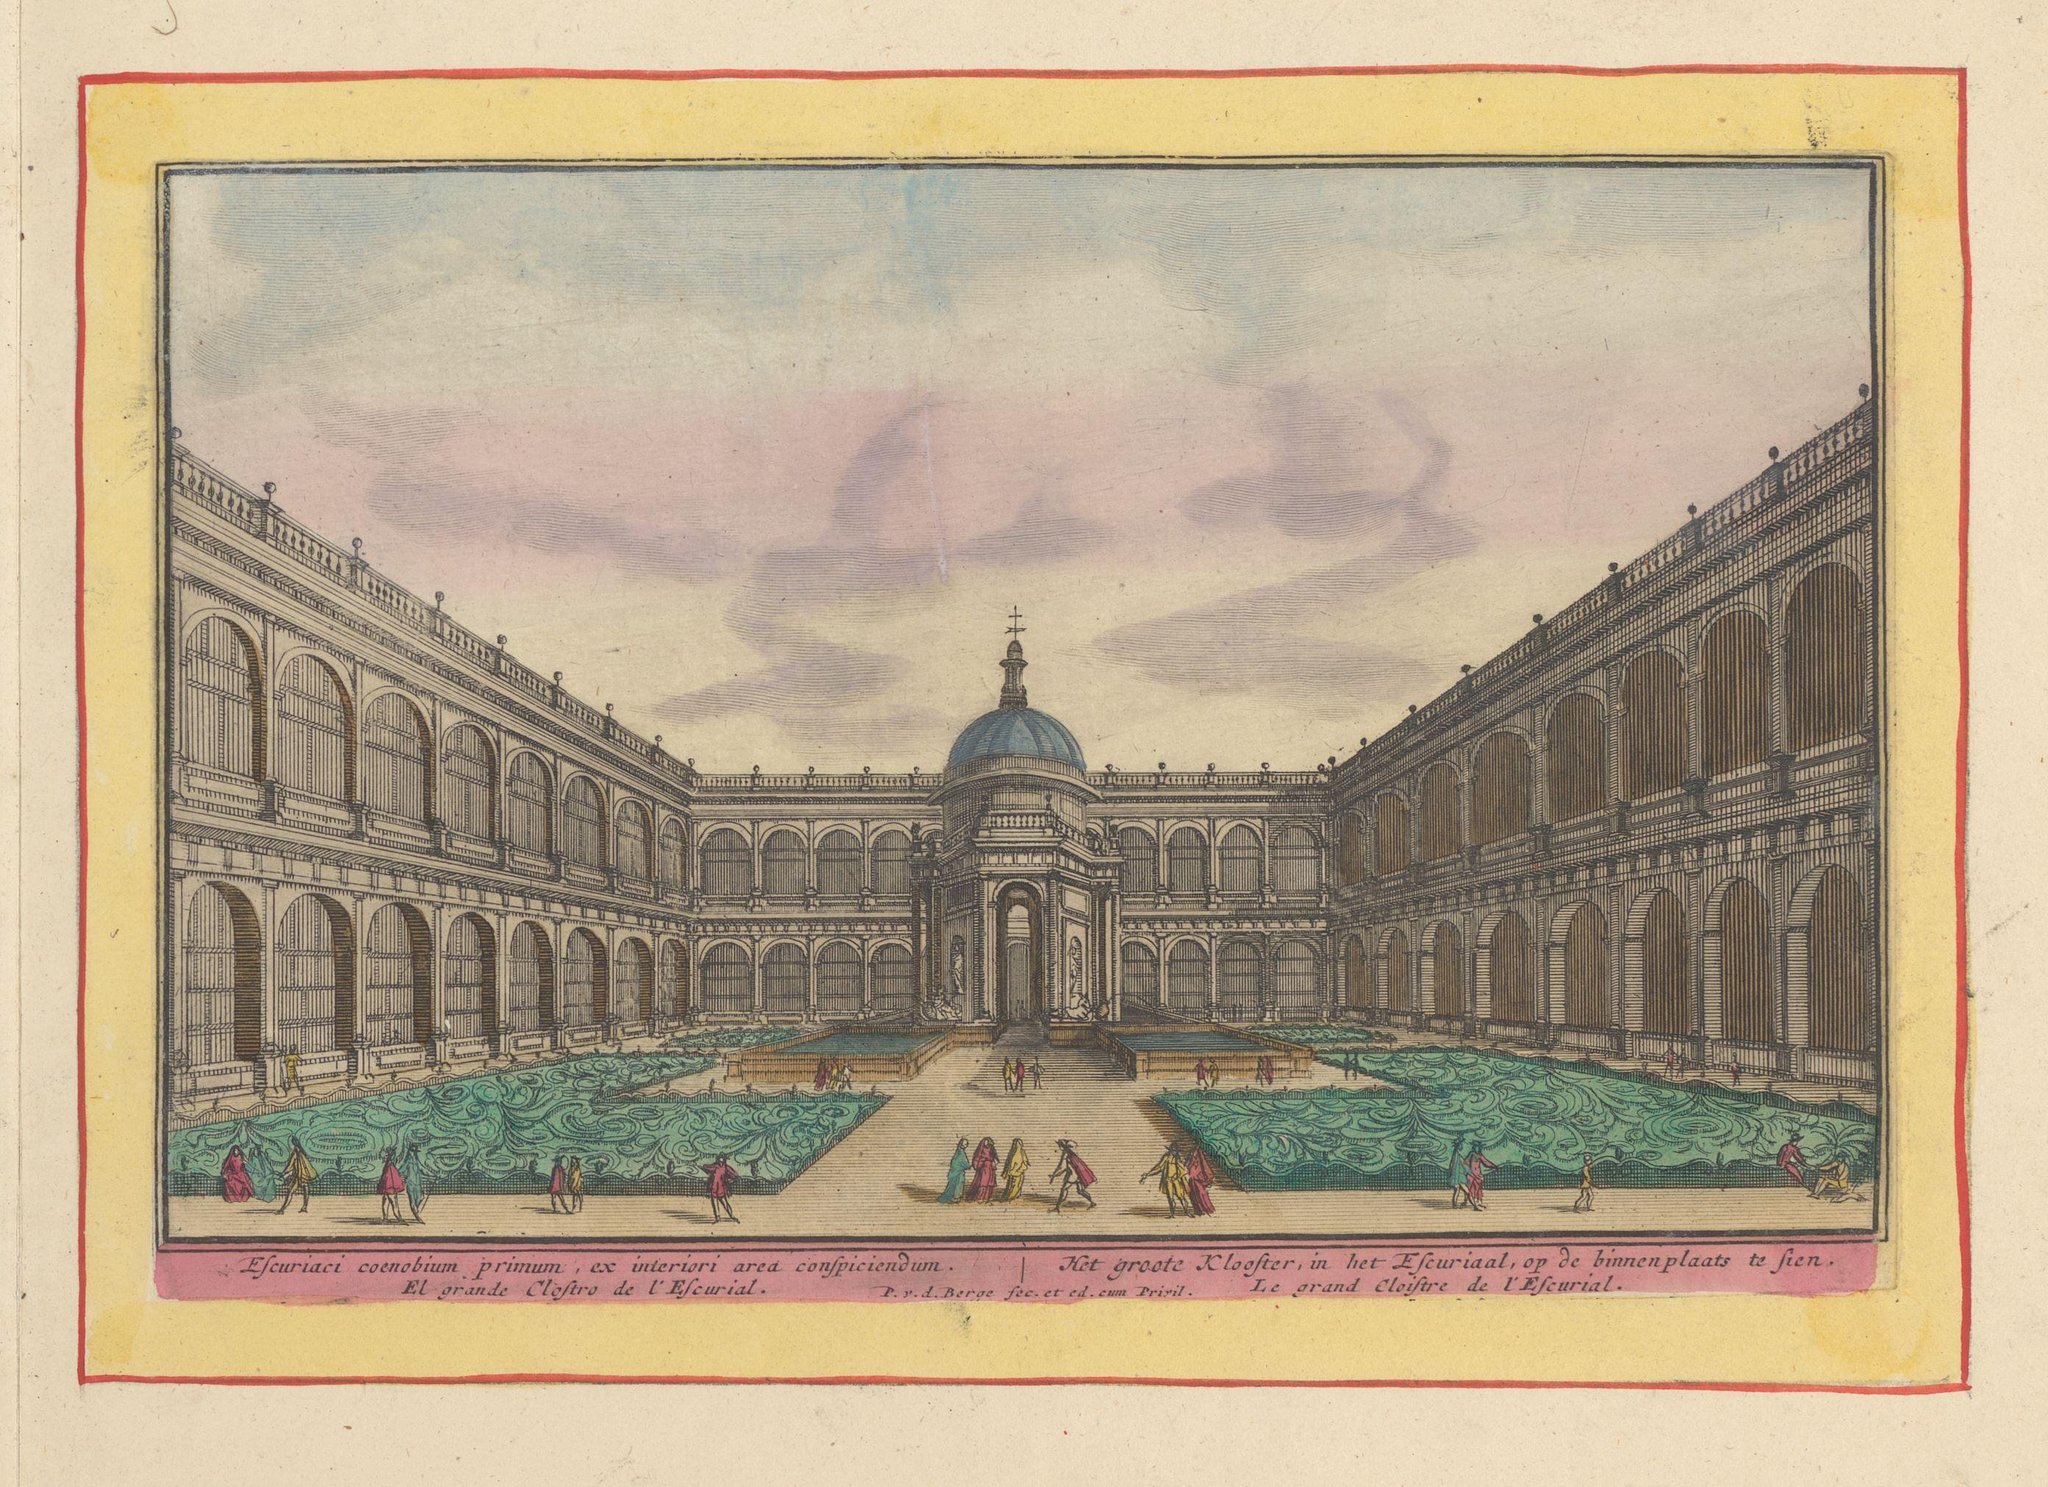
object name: album leaf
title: Theatrum Hispaniae (...)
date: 1694-1737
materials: paper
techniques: etching, hand coloring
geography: the hague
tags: abbey, monastery, convent ~ roman catholic church, courtyard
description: Prent uit: Theatrum Hispaniæ, exhibens regni urbes, villas ac viridaria magis illustria. Het aanmerkelykste en voortreffelykste in Spanjen (...). Amsterdam: Pieter van den Berge, ca. 1694-1737.